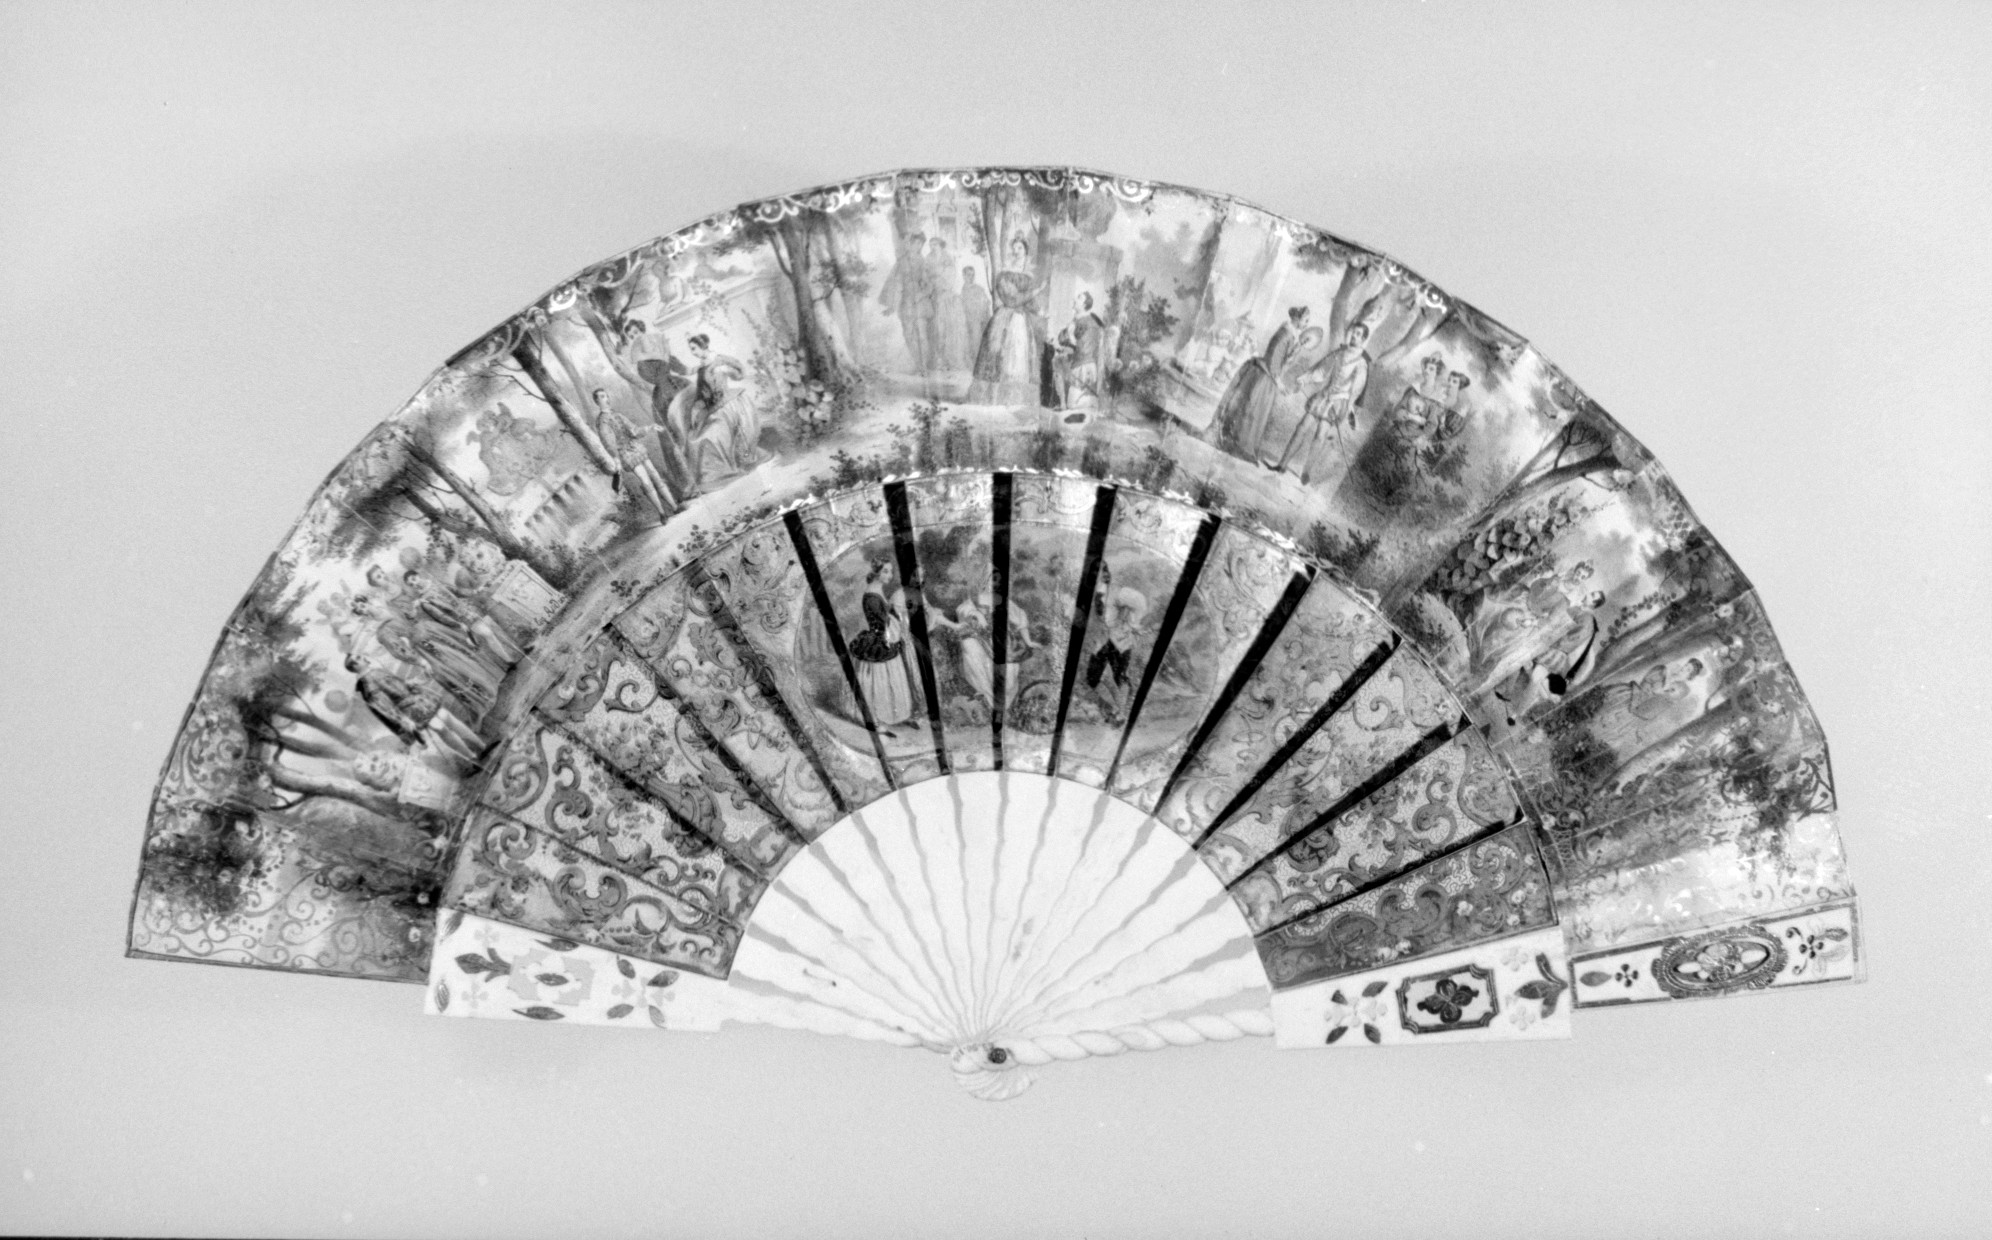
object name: fan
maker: eugene andion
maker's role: designer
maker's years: 1800-1900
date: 1834-1866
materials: gilt, glass, gold, ivory, paint, paper, silver, wood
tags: men,women